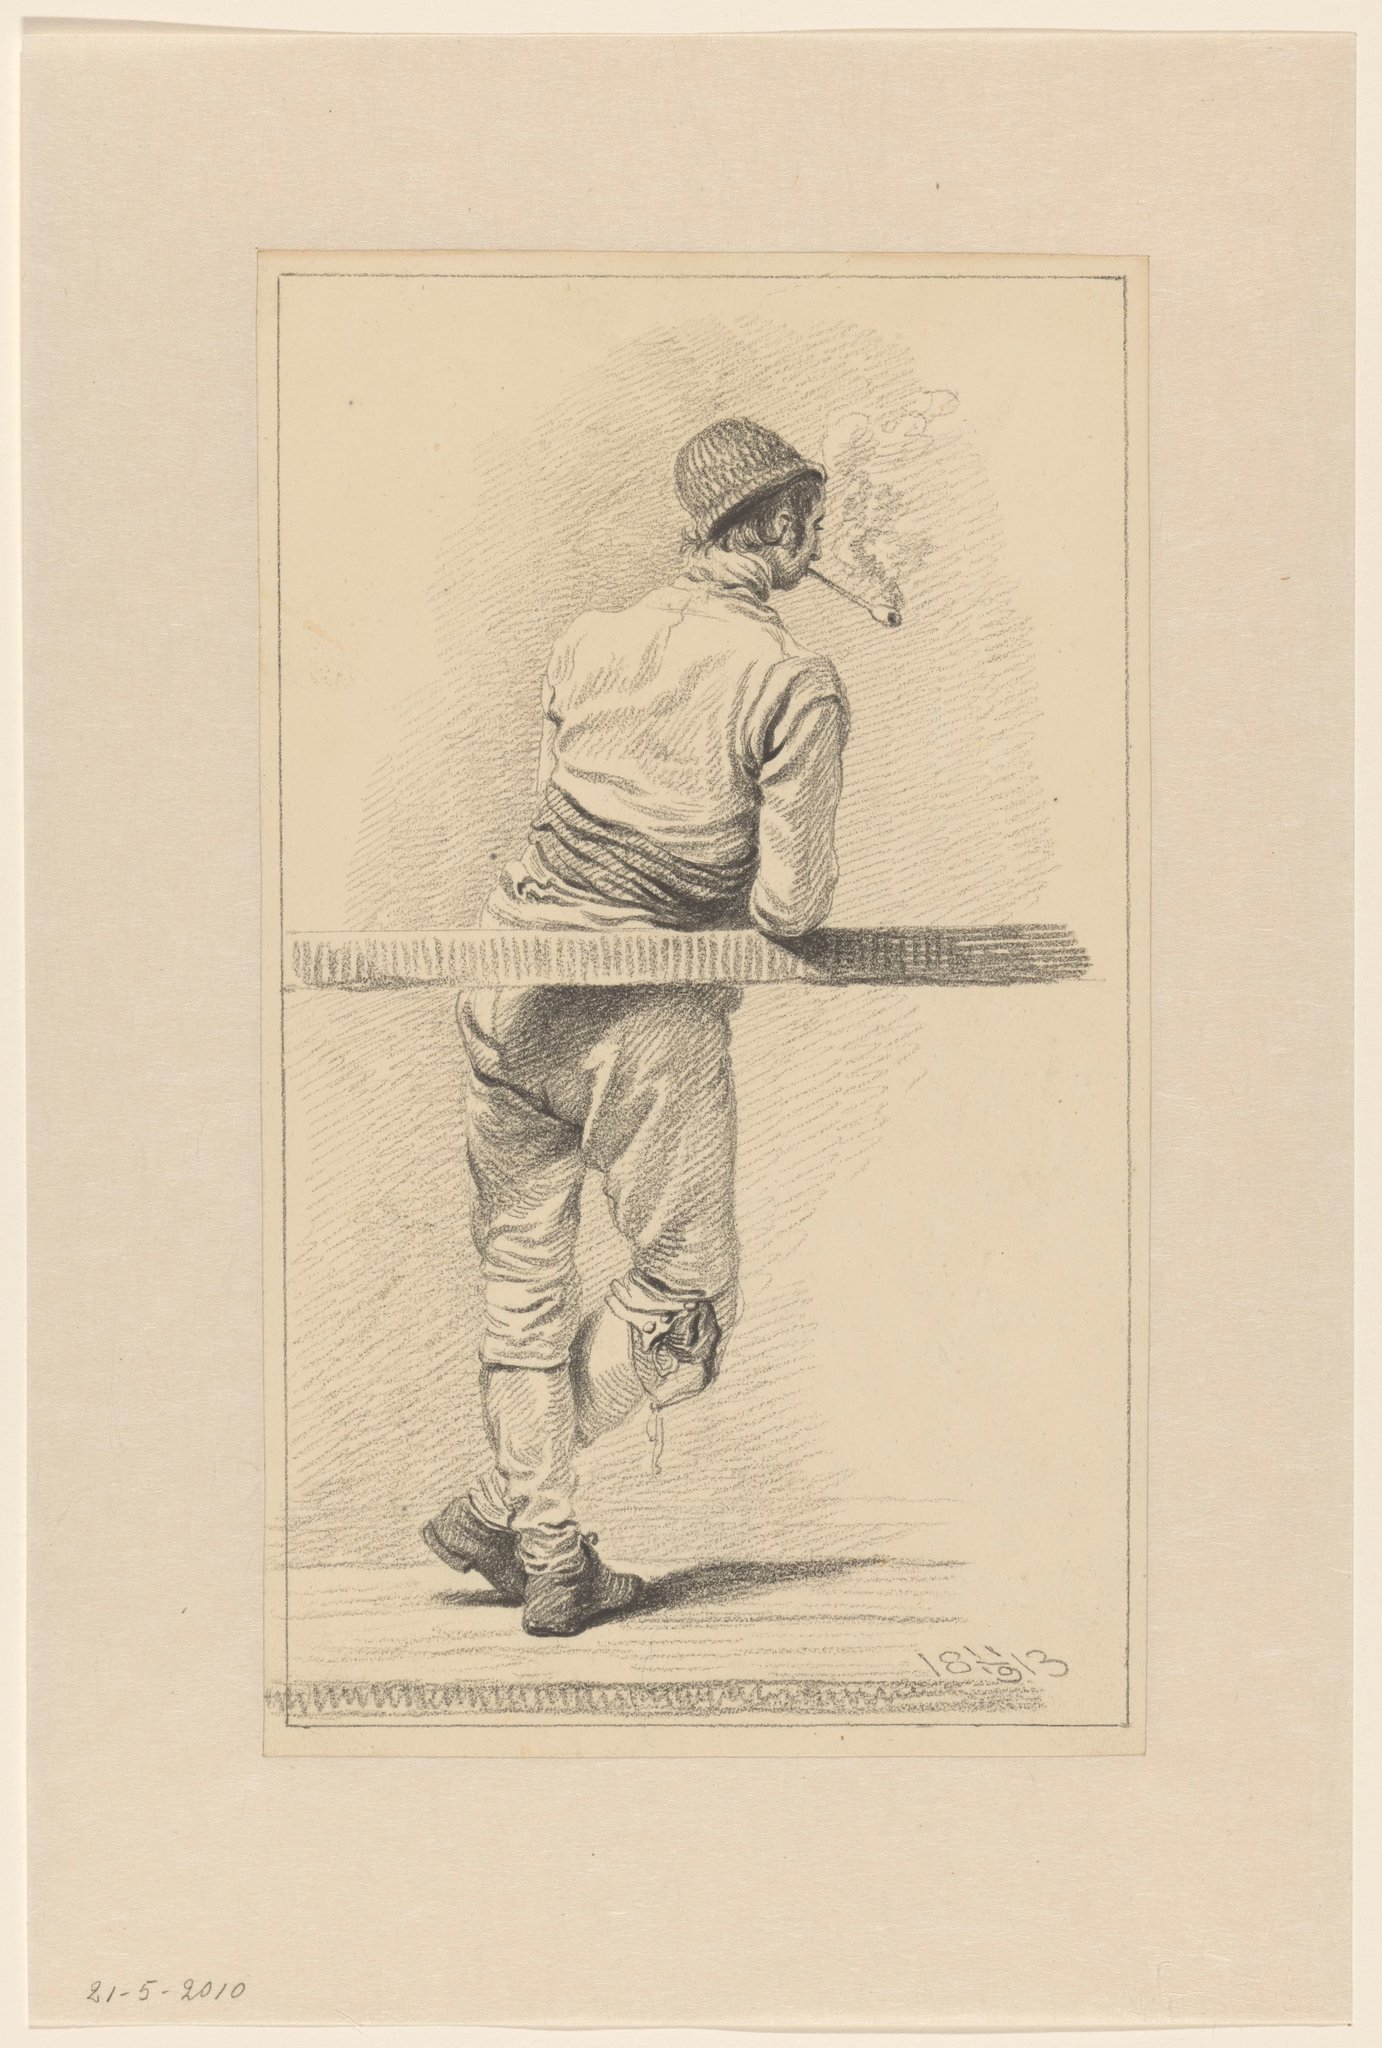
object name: drawing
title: Rokende jongeman, van achteren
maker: joannes pieter visser bender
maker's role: draughtsman, print maker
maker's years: 1785-1813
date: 1813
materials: chalk, paper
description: Jongeman van achteren, leunend op een balk, terwijl hij rookt.